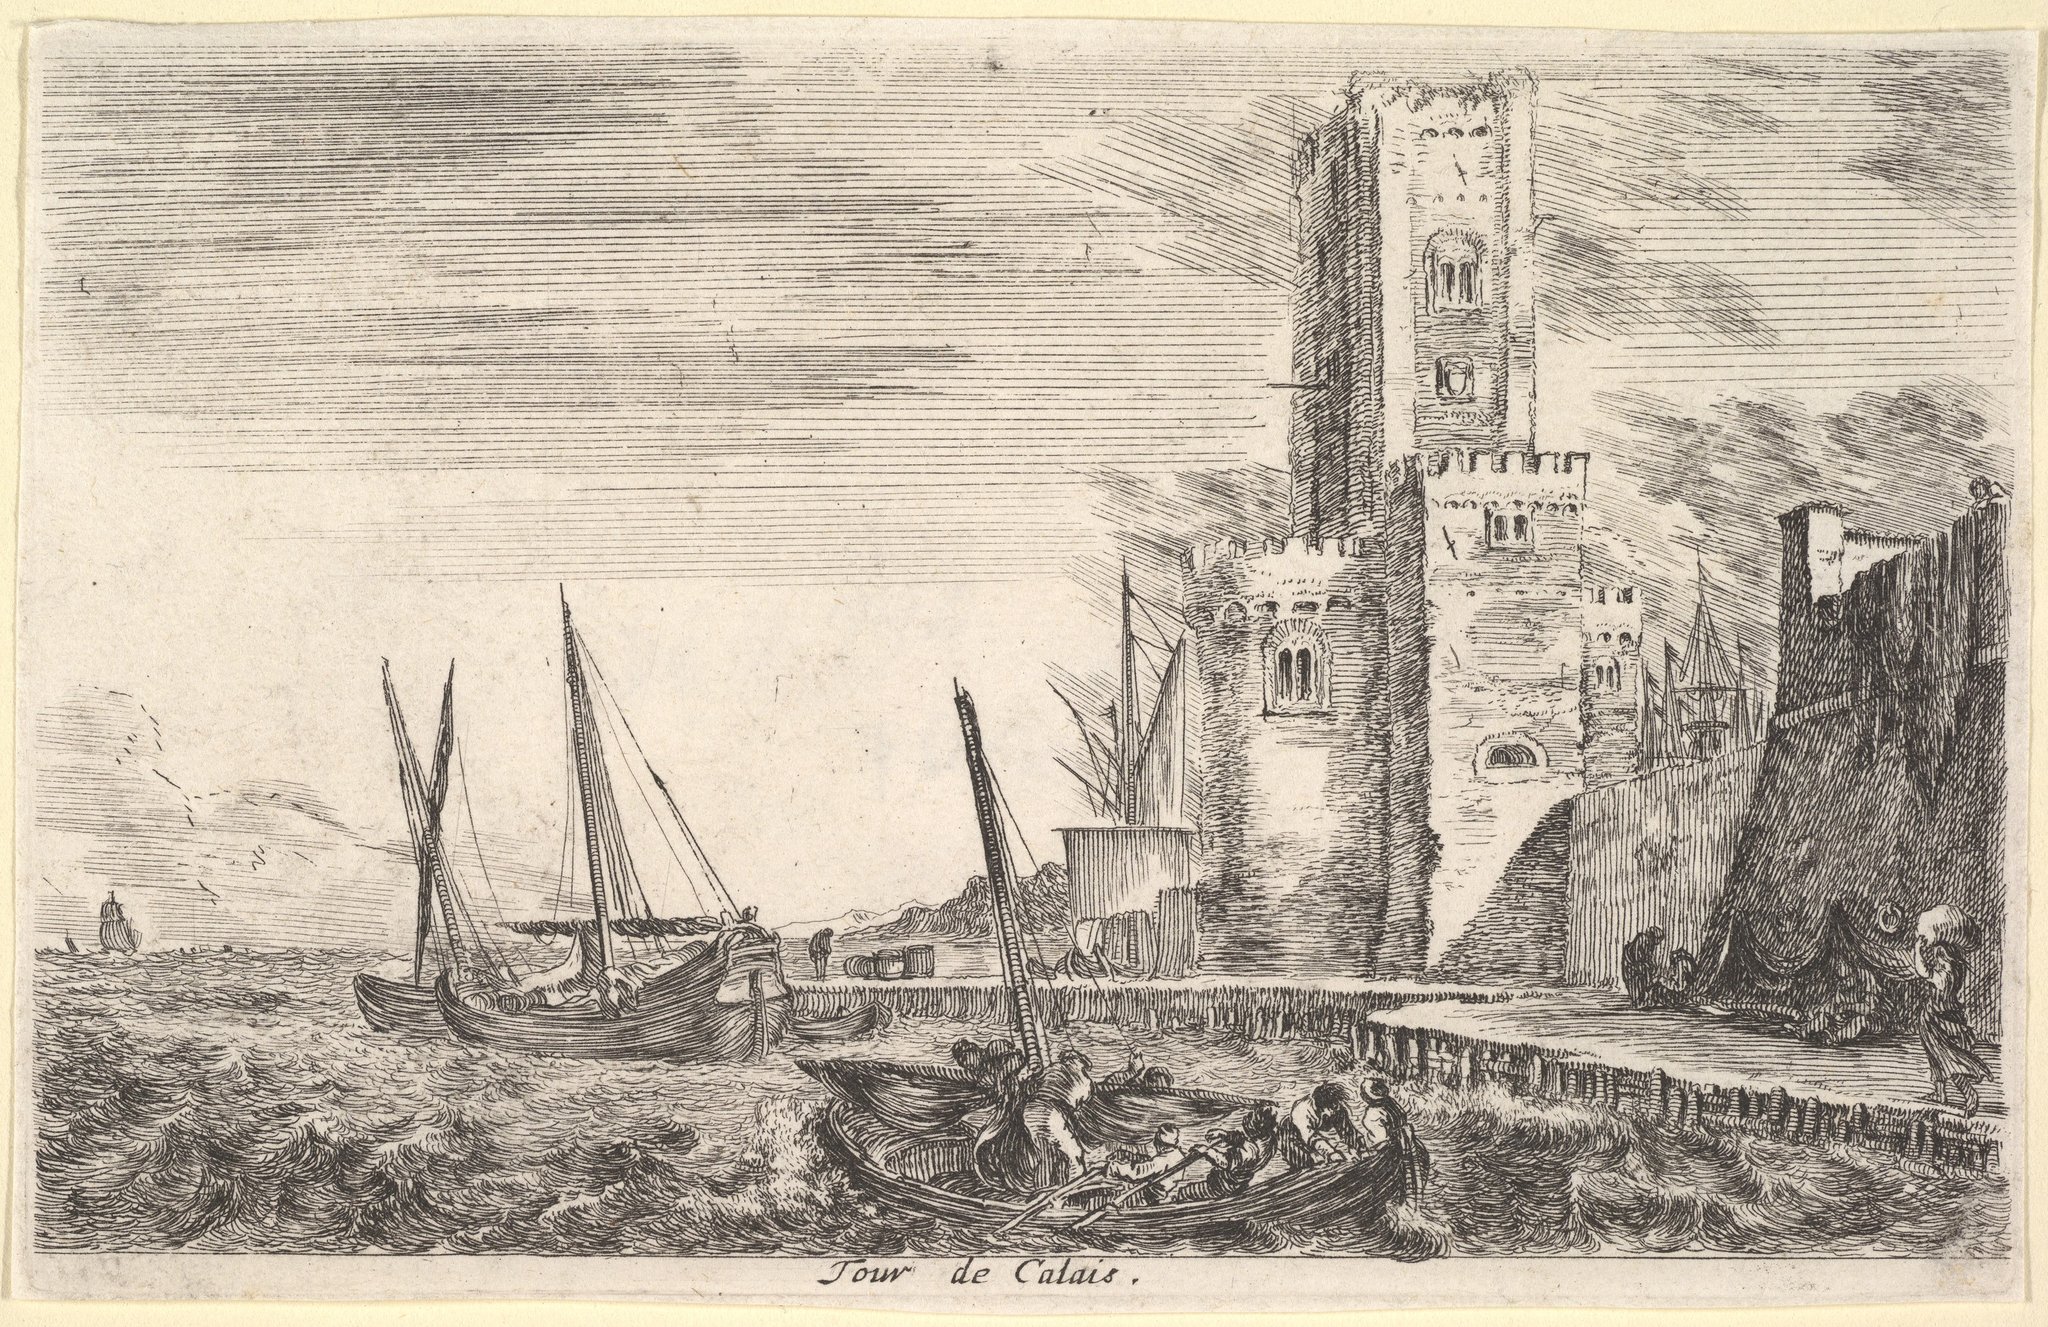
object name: print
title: Tower of Calais (Tour de Calais), from "Views of seaports" (Vues de ports de mar)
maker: stefano della bella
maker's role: artist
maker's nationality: italian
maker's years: 1610-1664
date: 1647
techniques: etching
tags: towers,men,seas,waves,ships